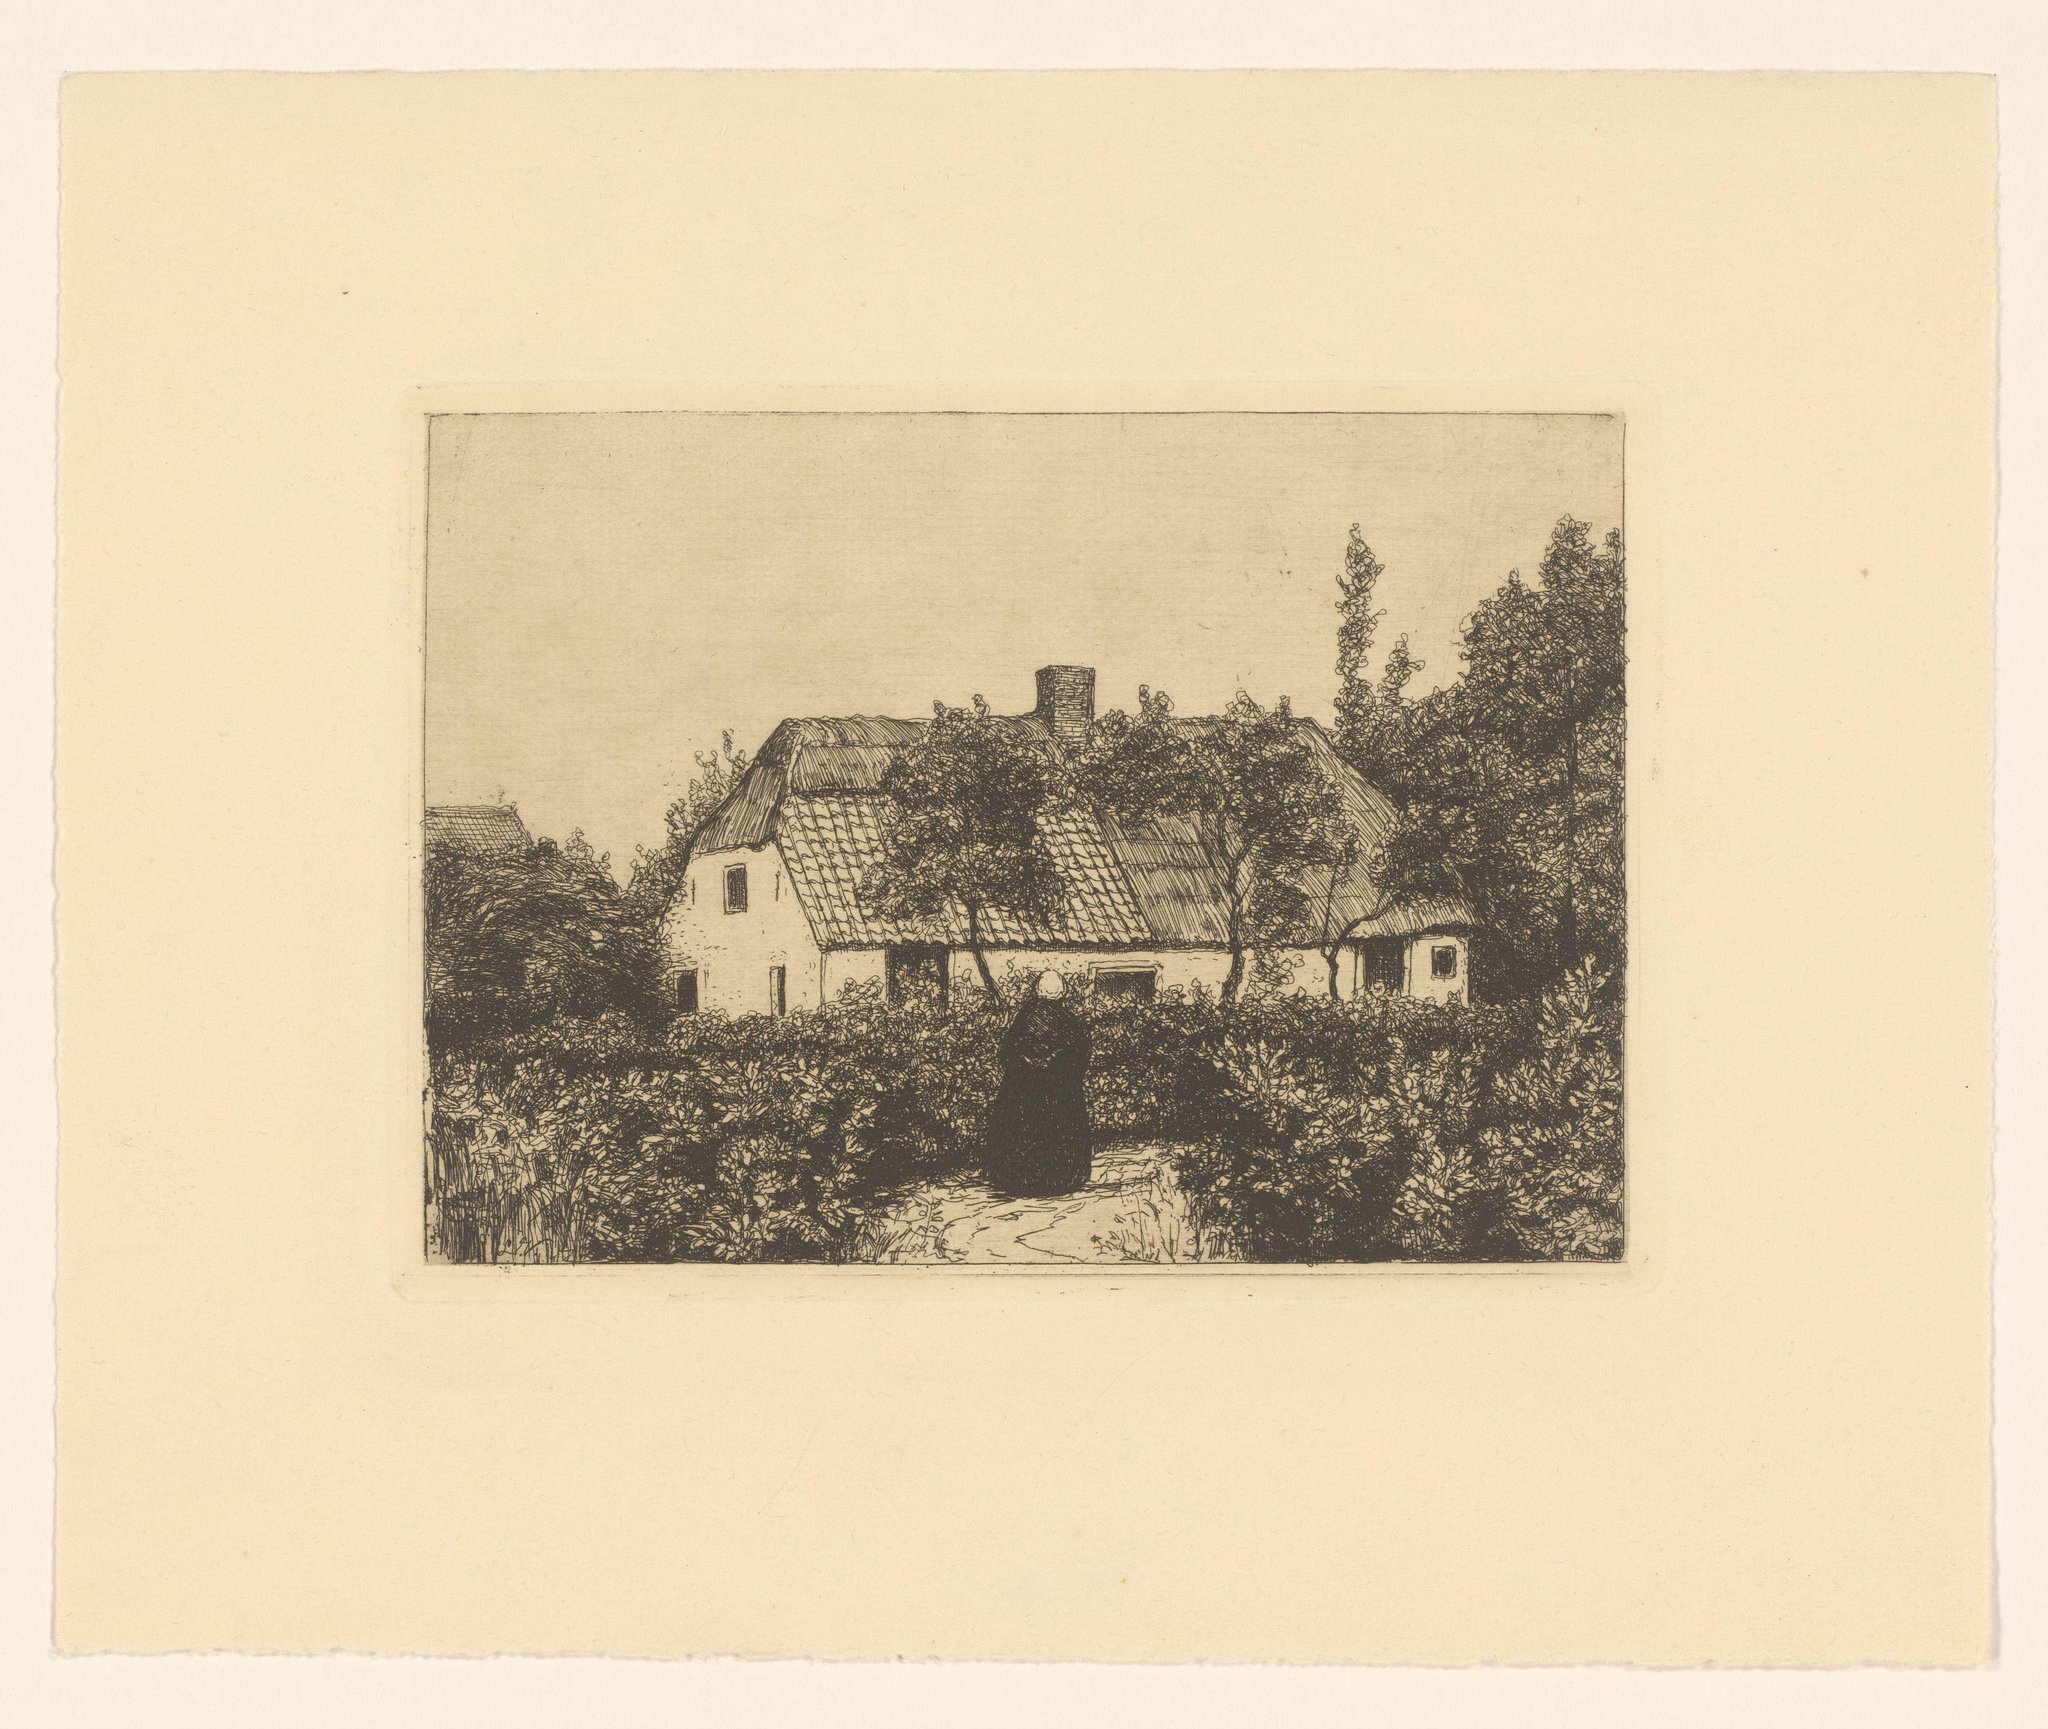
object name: print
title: Huis met bomen en figuur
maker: laurent verwey van udenhout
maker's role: print maker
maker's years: 1884-1913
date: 1894-1913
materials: paper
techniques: etching, intaglio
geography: netherlands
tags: standing figure, trees, rural housing, e.g. country-house, villa, cottage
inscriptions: collector's mark: Lugt 2228